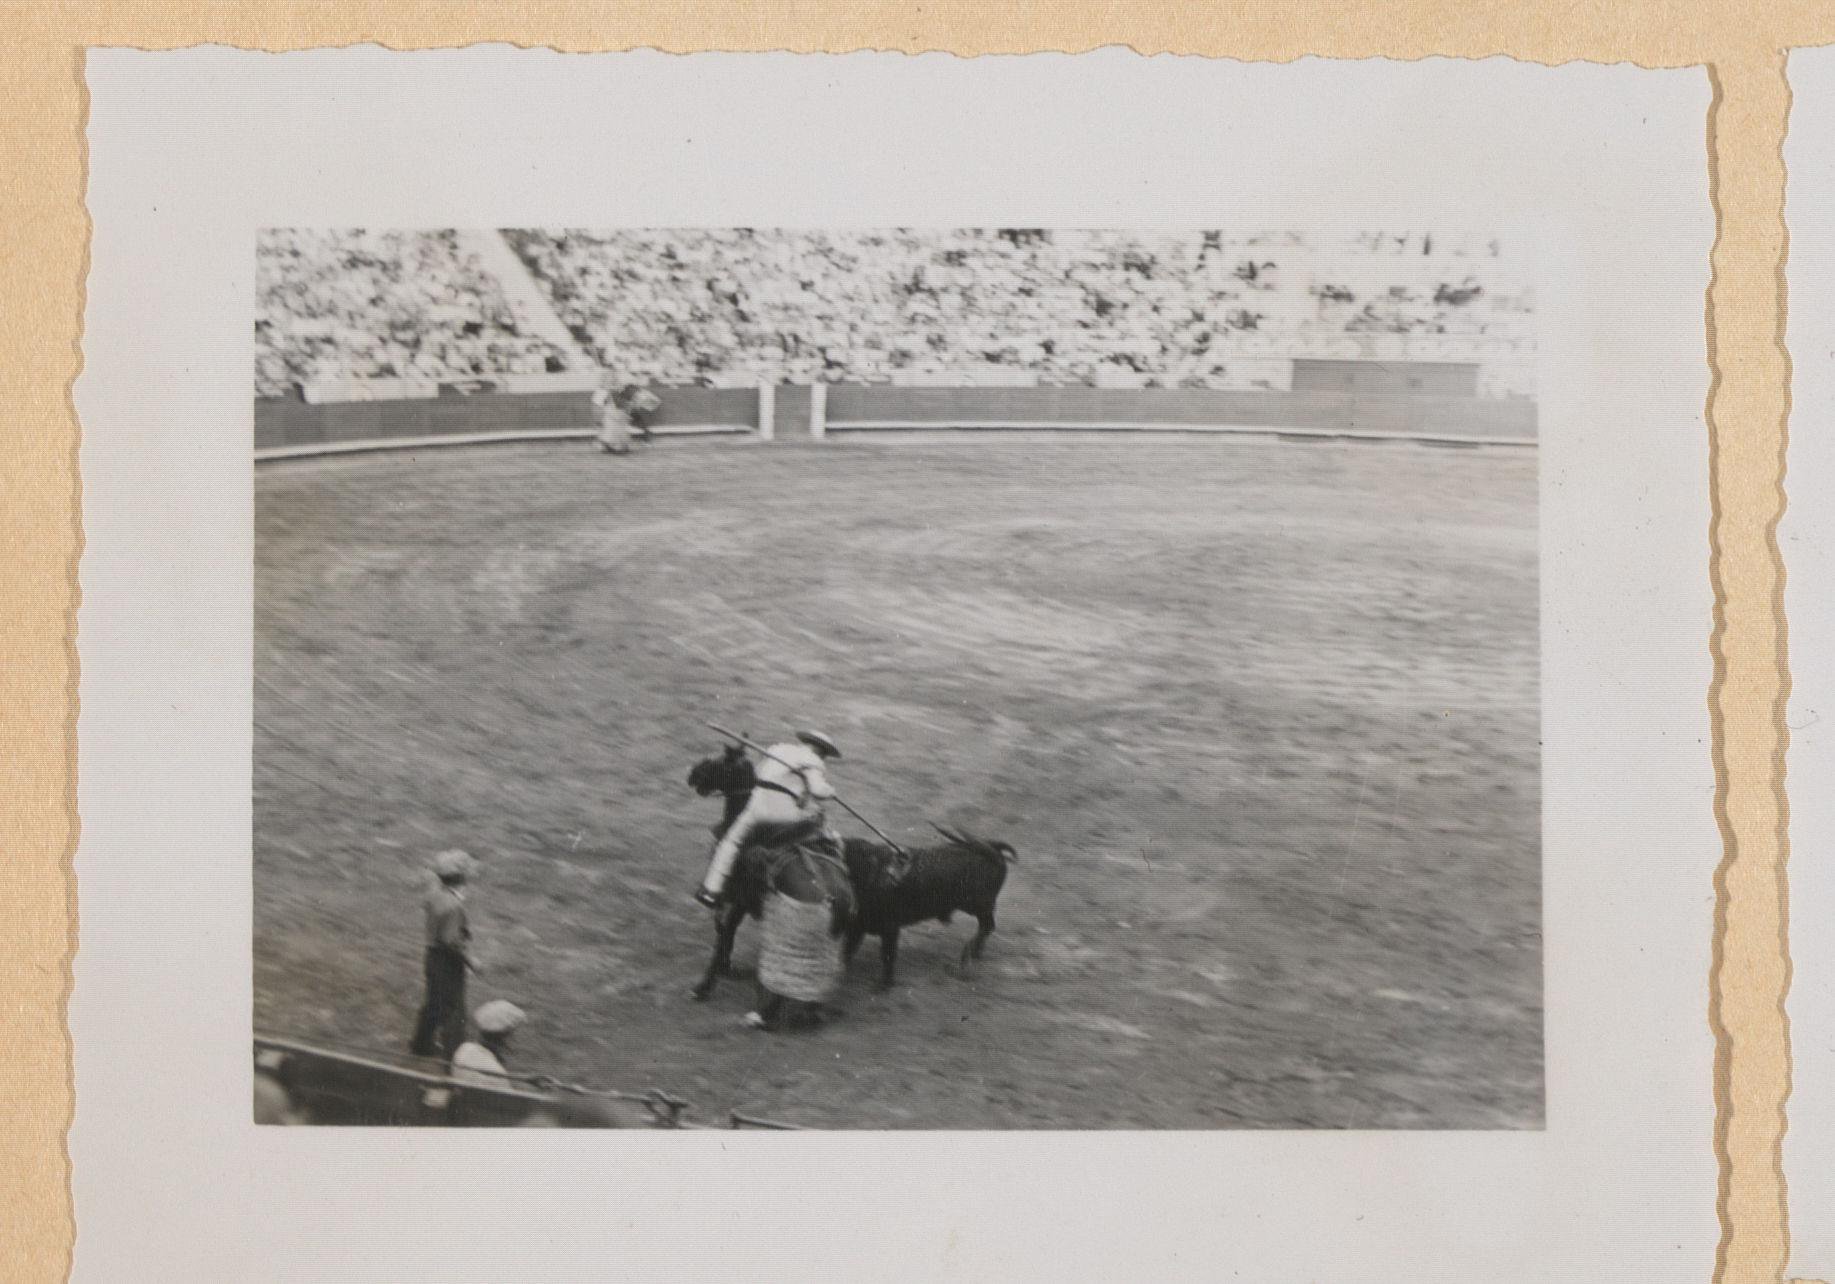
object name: album leaf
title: Le jeu des picadores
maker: Anonymous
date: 1955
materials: paper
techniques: gelatin silver print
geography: barcelona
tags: riding a horse, ass, or mule; rider, horseman, bullfight